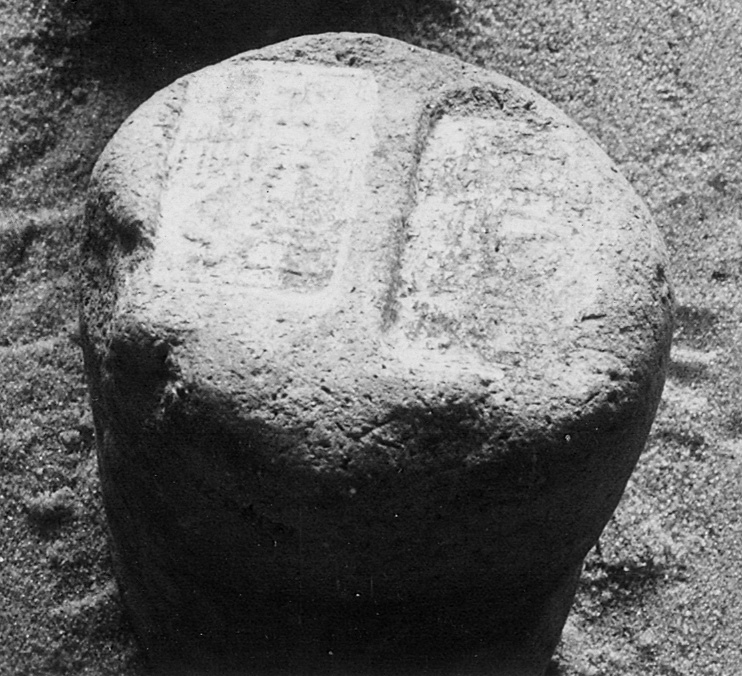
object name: cone, rectangular 2 impression, djehutimose, wab priest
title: Funerary Cone of Djehutymose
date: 1550-1295 BCE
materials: pottery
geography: egypt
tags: hieroglyphs